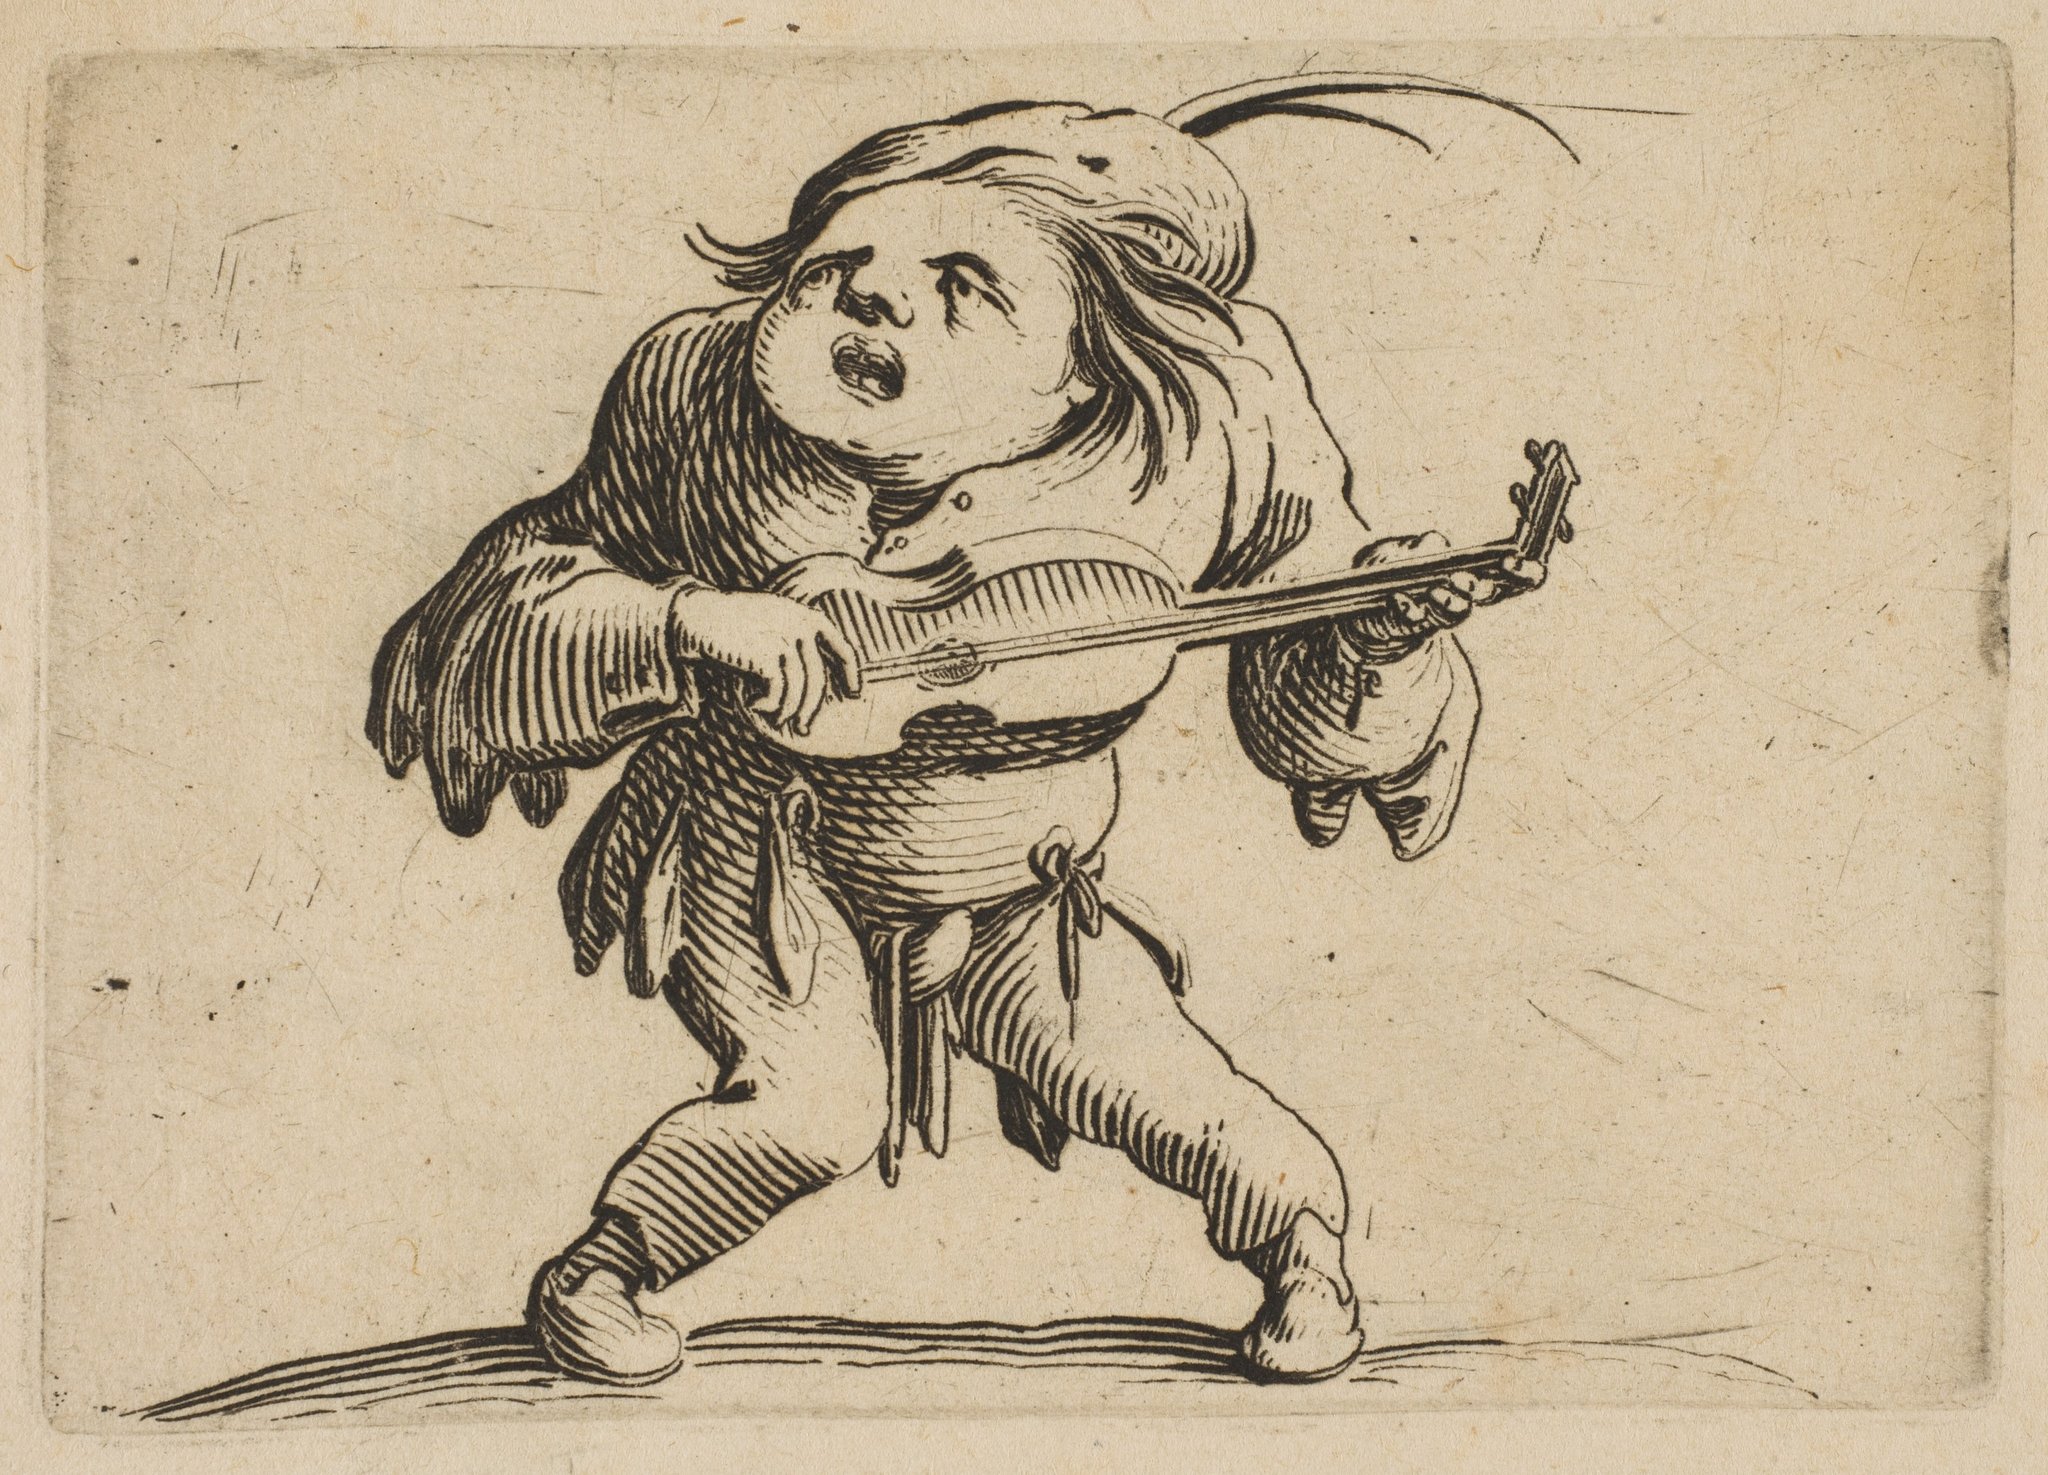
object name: print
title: Le Bancal Jouant de La Guitar (The Bandy-Legged Man Playing the Guitar), from "Varie Figure Gobbi, suite appelée aussi Les Bossus, Les Pygmées, Les Nains Grotesques" (Various Hunchbacked Figures, The Hunchbacks, The Pygmes, The Grotesque Dwarfs)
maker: jacques callot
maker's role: artist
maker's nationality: french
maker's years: 1592-1635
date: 1616-1622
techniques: engraving, etching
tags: men,guitars,musicians